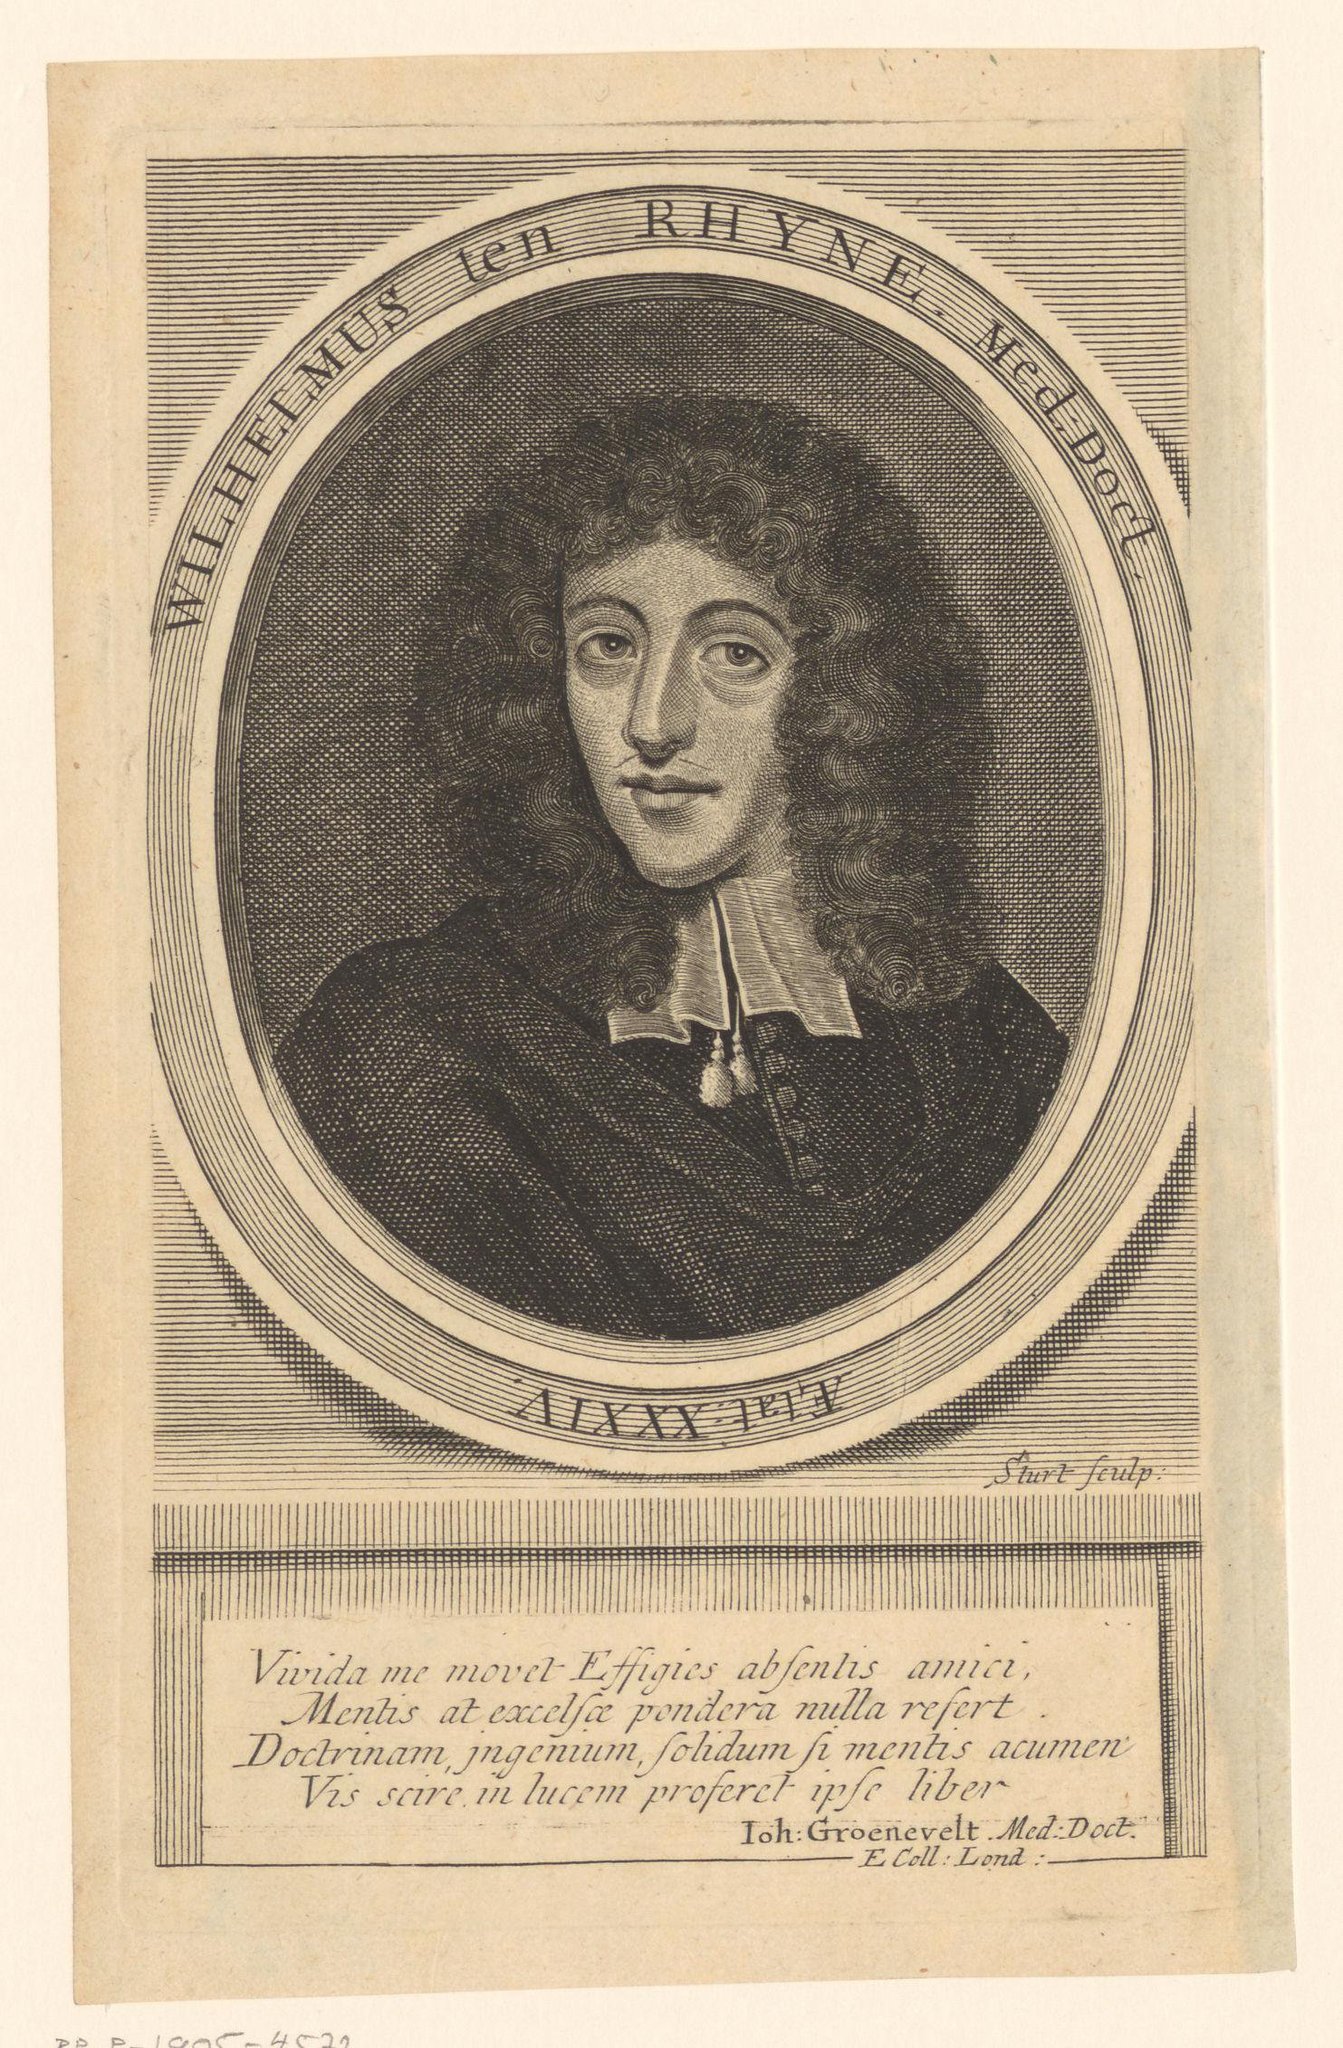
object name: book illustration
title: Portret van Willem ten Rhijne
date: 1683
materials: paper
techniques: engraving, etching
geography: london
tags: deventer, willem ten rhijne, historical persons, physician, doctor (+ portrait of scholar, scientist)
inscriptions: collector's mark: Lugt 2228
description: Prent uit: Rhijne, Willem ten. Dissertatio de arthritide (...). Londen: Richard Chiswell, 1683.